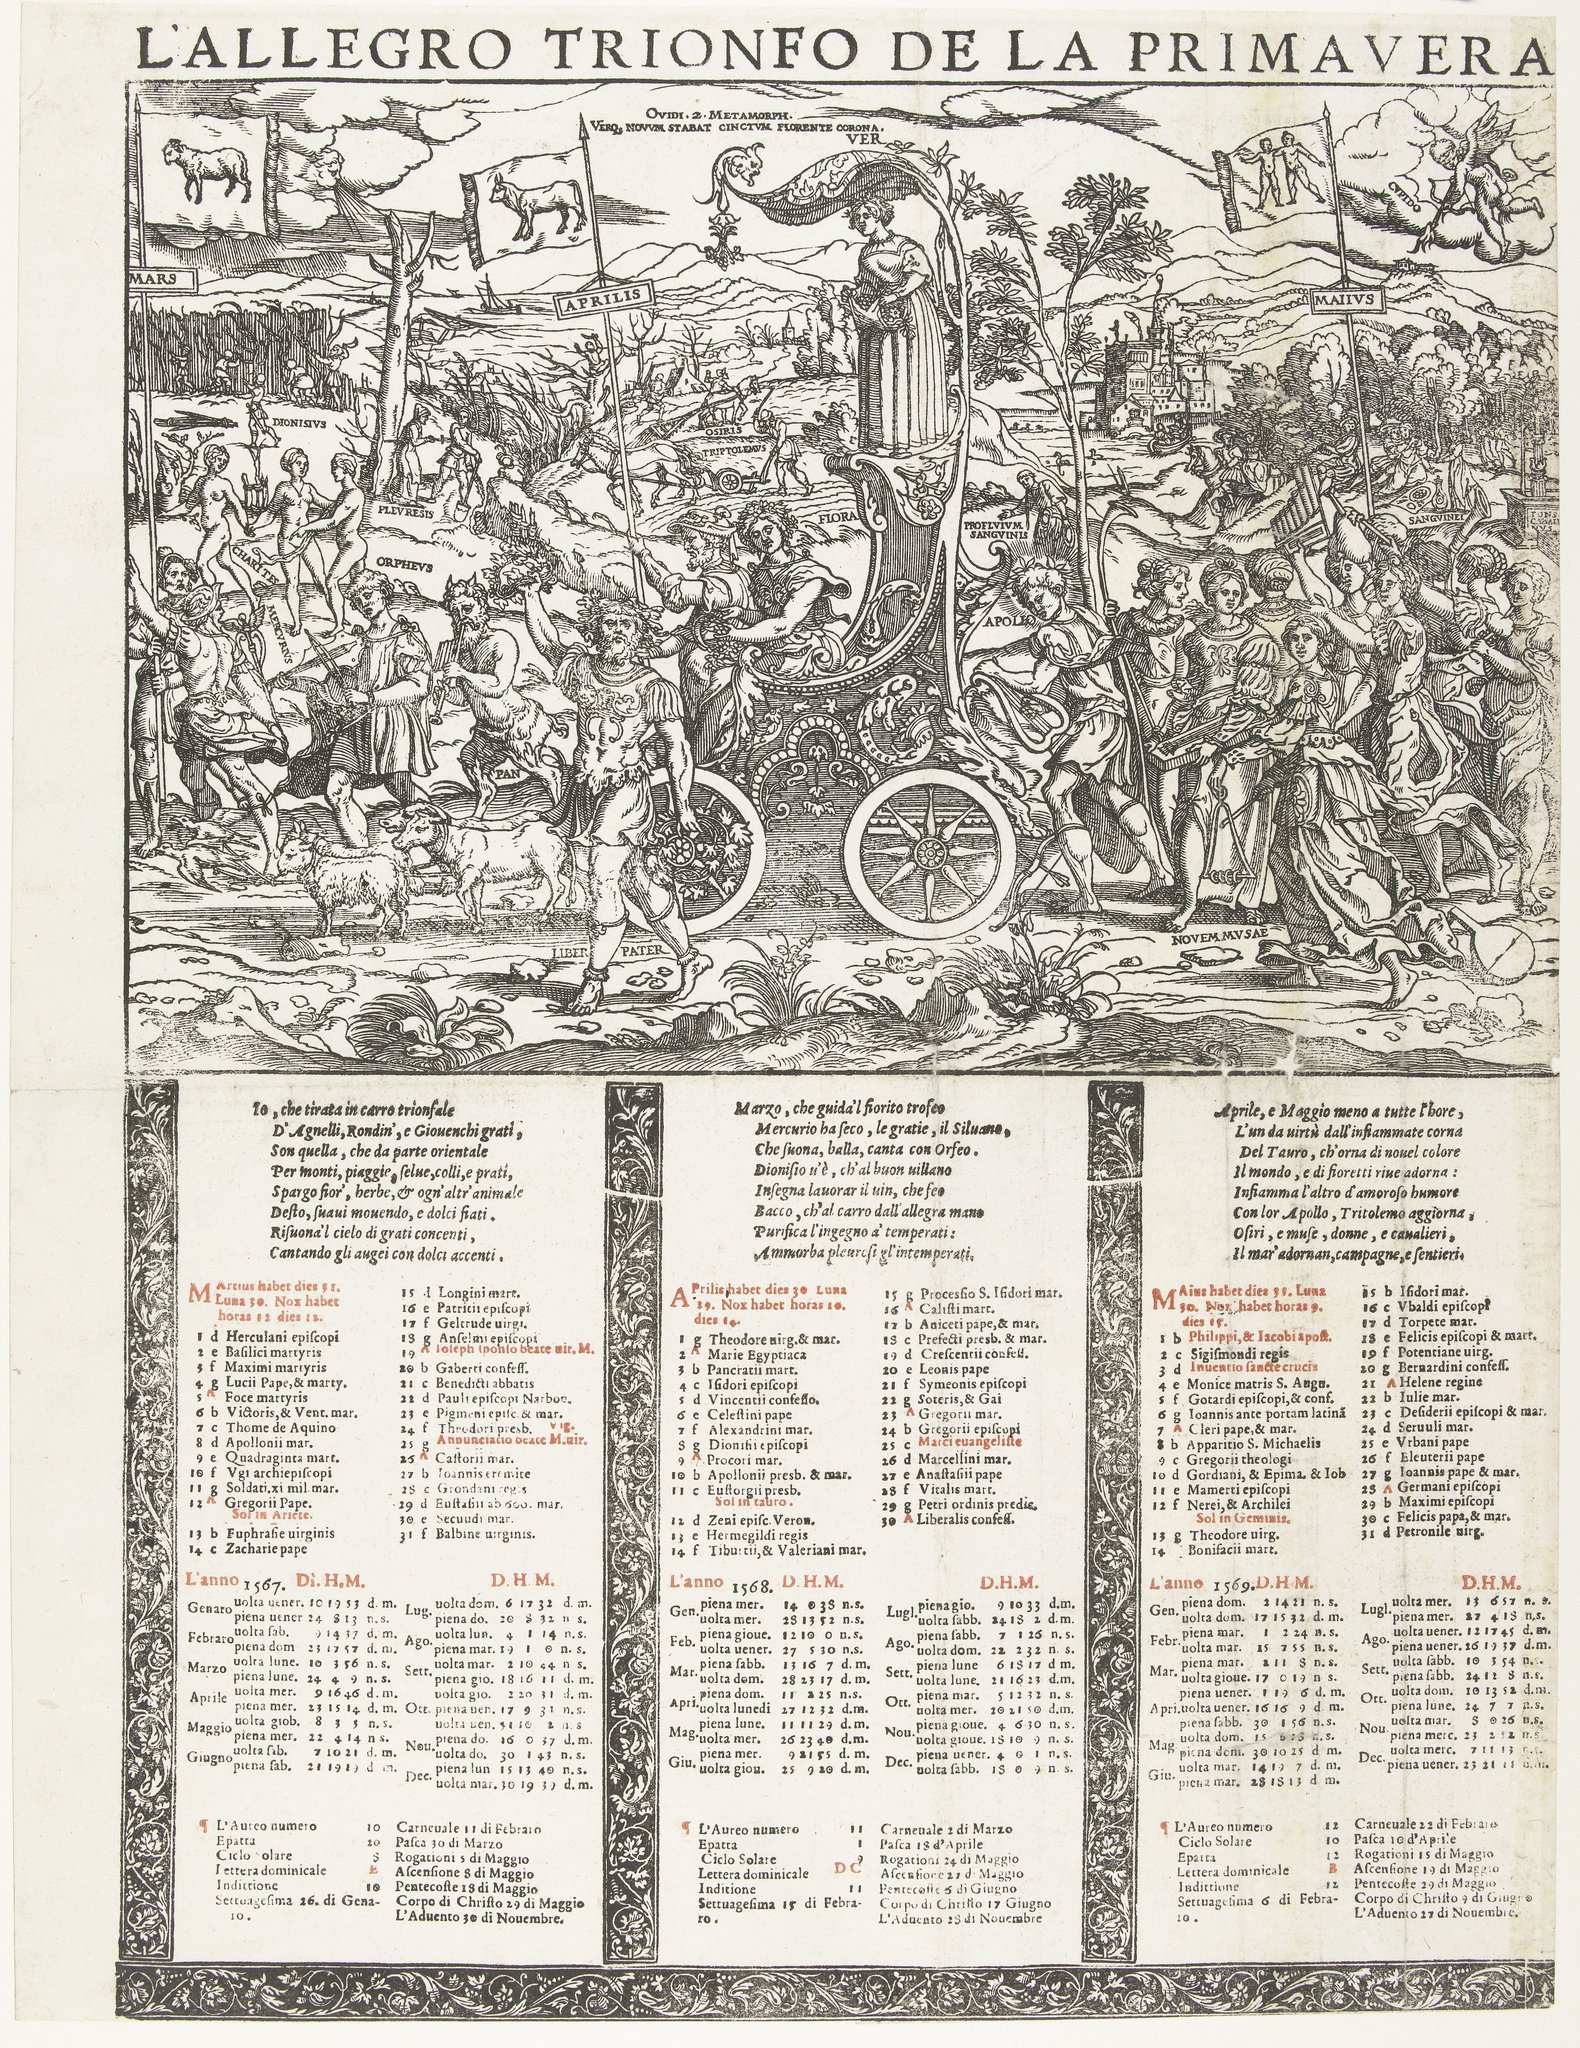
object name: print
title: L'Allegro Trionfo de la Primavera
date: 1537-1550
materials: paper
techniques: woodcut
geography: italy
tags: spring, 'ver'; 'primavera' (ripa), calendar of ecclesiastical feasts, chariot, triumphal car, soil cultivation, seasons of the year (esp. personifications); 'stagione', 'le quattro stagione dell'anno' (ripa) (+ with zodiacal signs of the spring season), (story of) flora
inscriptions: collector's mark: Lugt 2228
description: Eén van vier bladen van een kalender. Triomfoptocht van de lente: Flora in een triomfwagen getrokken door twee vogels, twee schapen en twee koeien, begeleid door verschillende personen en personficaties. Op de achtergrond een picknick en het bewerken van het land. De maanden maart, april en mei verbeeld door vlaggen met de sterrenbeelden. Onder de afbeelding kalender van de drie lentemaanden.